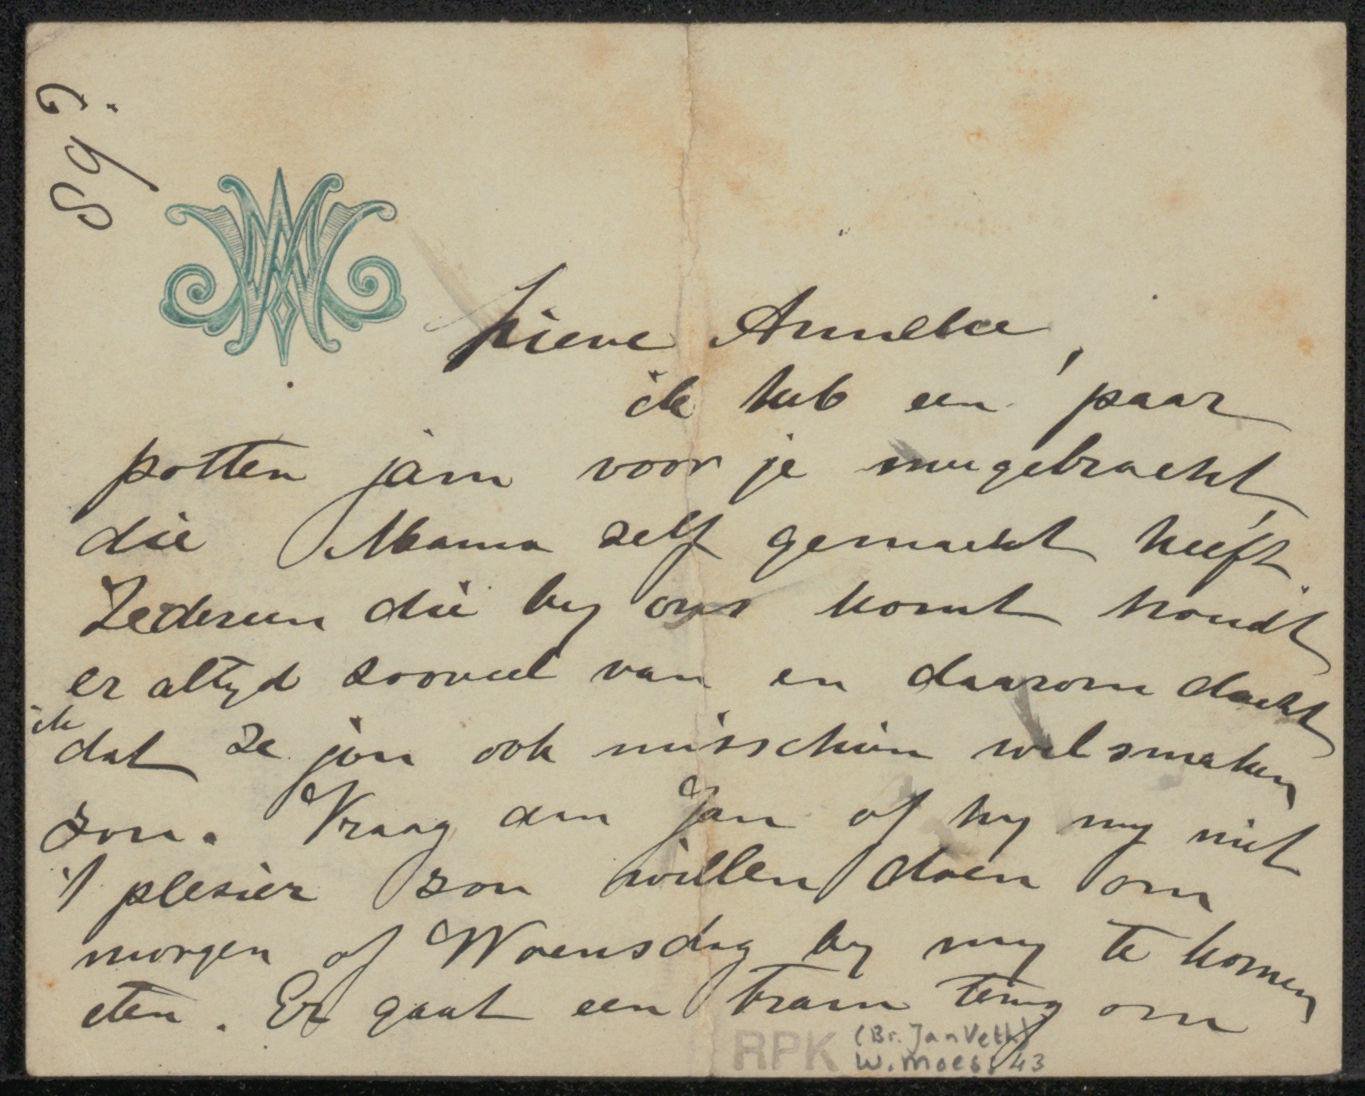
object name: letter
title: Brief aan Anna Dorothea Dirks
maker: wally moes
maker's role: draughtsman, print maker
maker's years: 1856-1918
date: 1873-1918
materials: ink, paper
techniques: pen, writing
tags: painter, jan veth, artist, anna dorothea dirks, painting (including book-illumination, miniature-painting)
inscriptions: monogram: ‘WM’, collector's mark: ‘RPK’